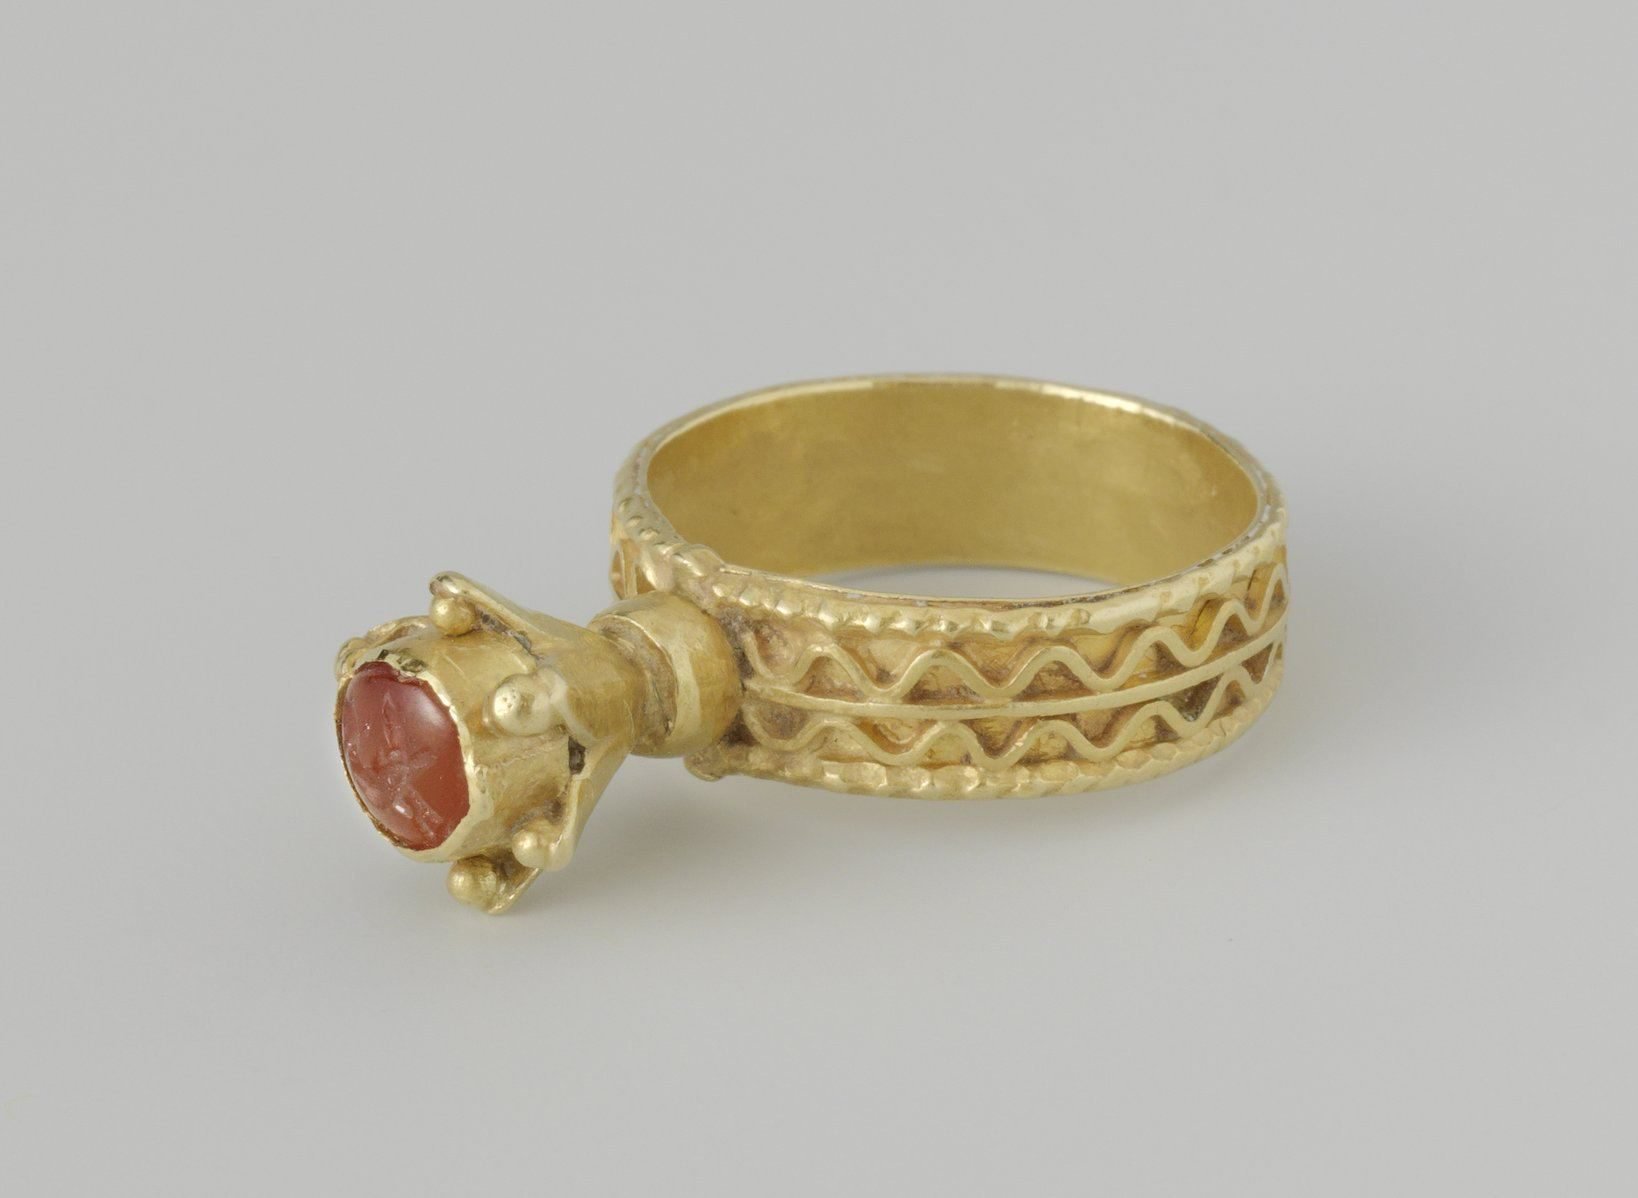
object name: ring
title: Ring met een gesneden kornalijn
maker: Anonymous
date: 500-700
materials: gemstone, gold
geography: byzantium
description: Ring. Gold, cornelian. Byzantine Empire, 5th - 6th century.